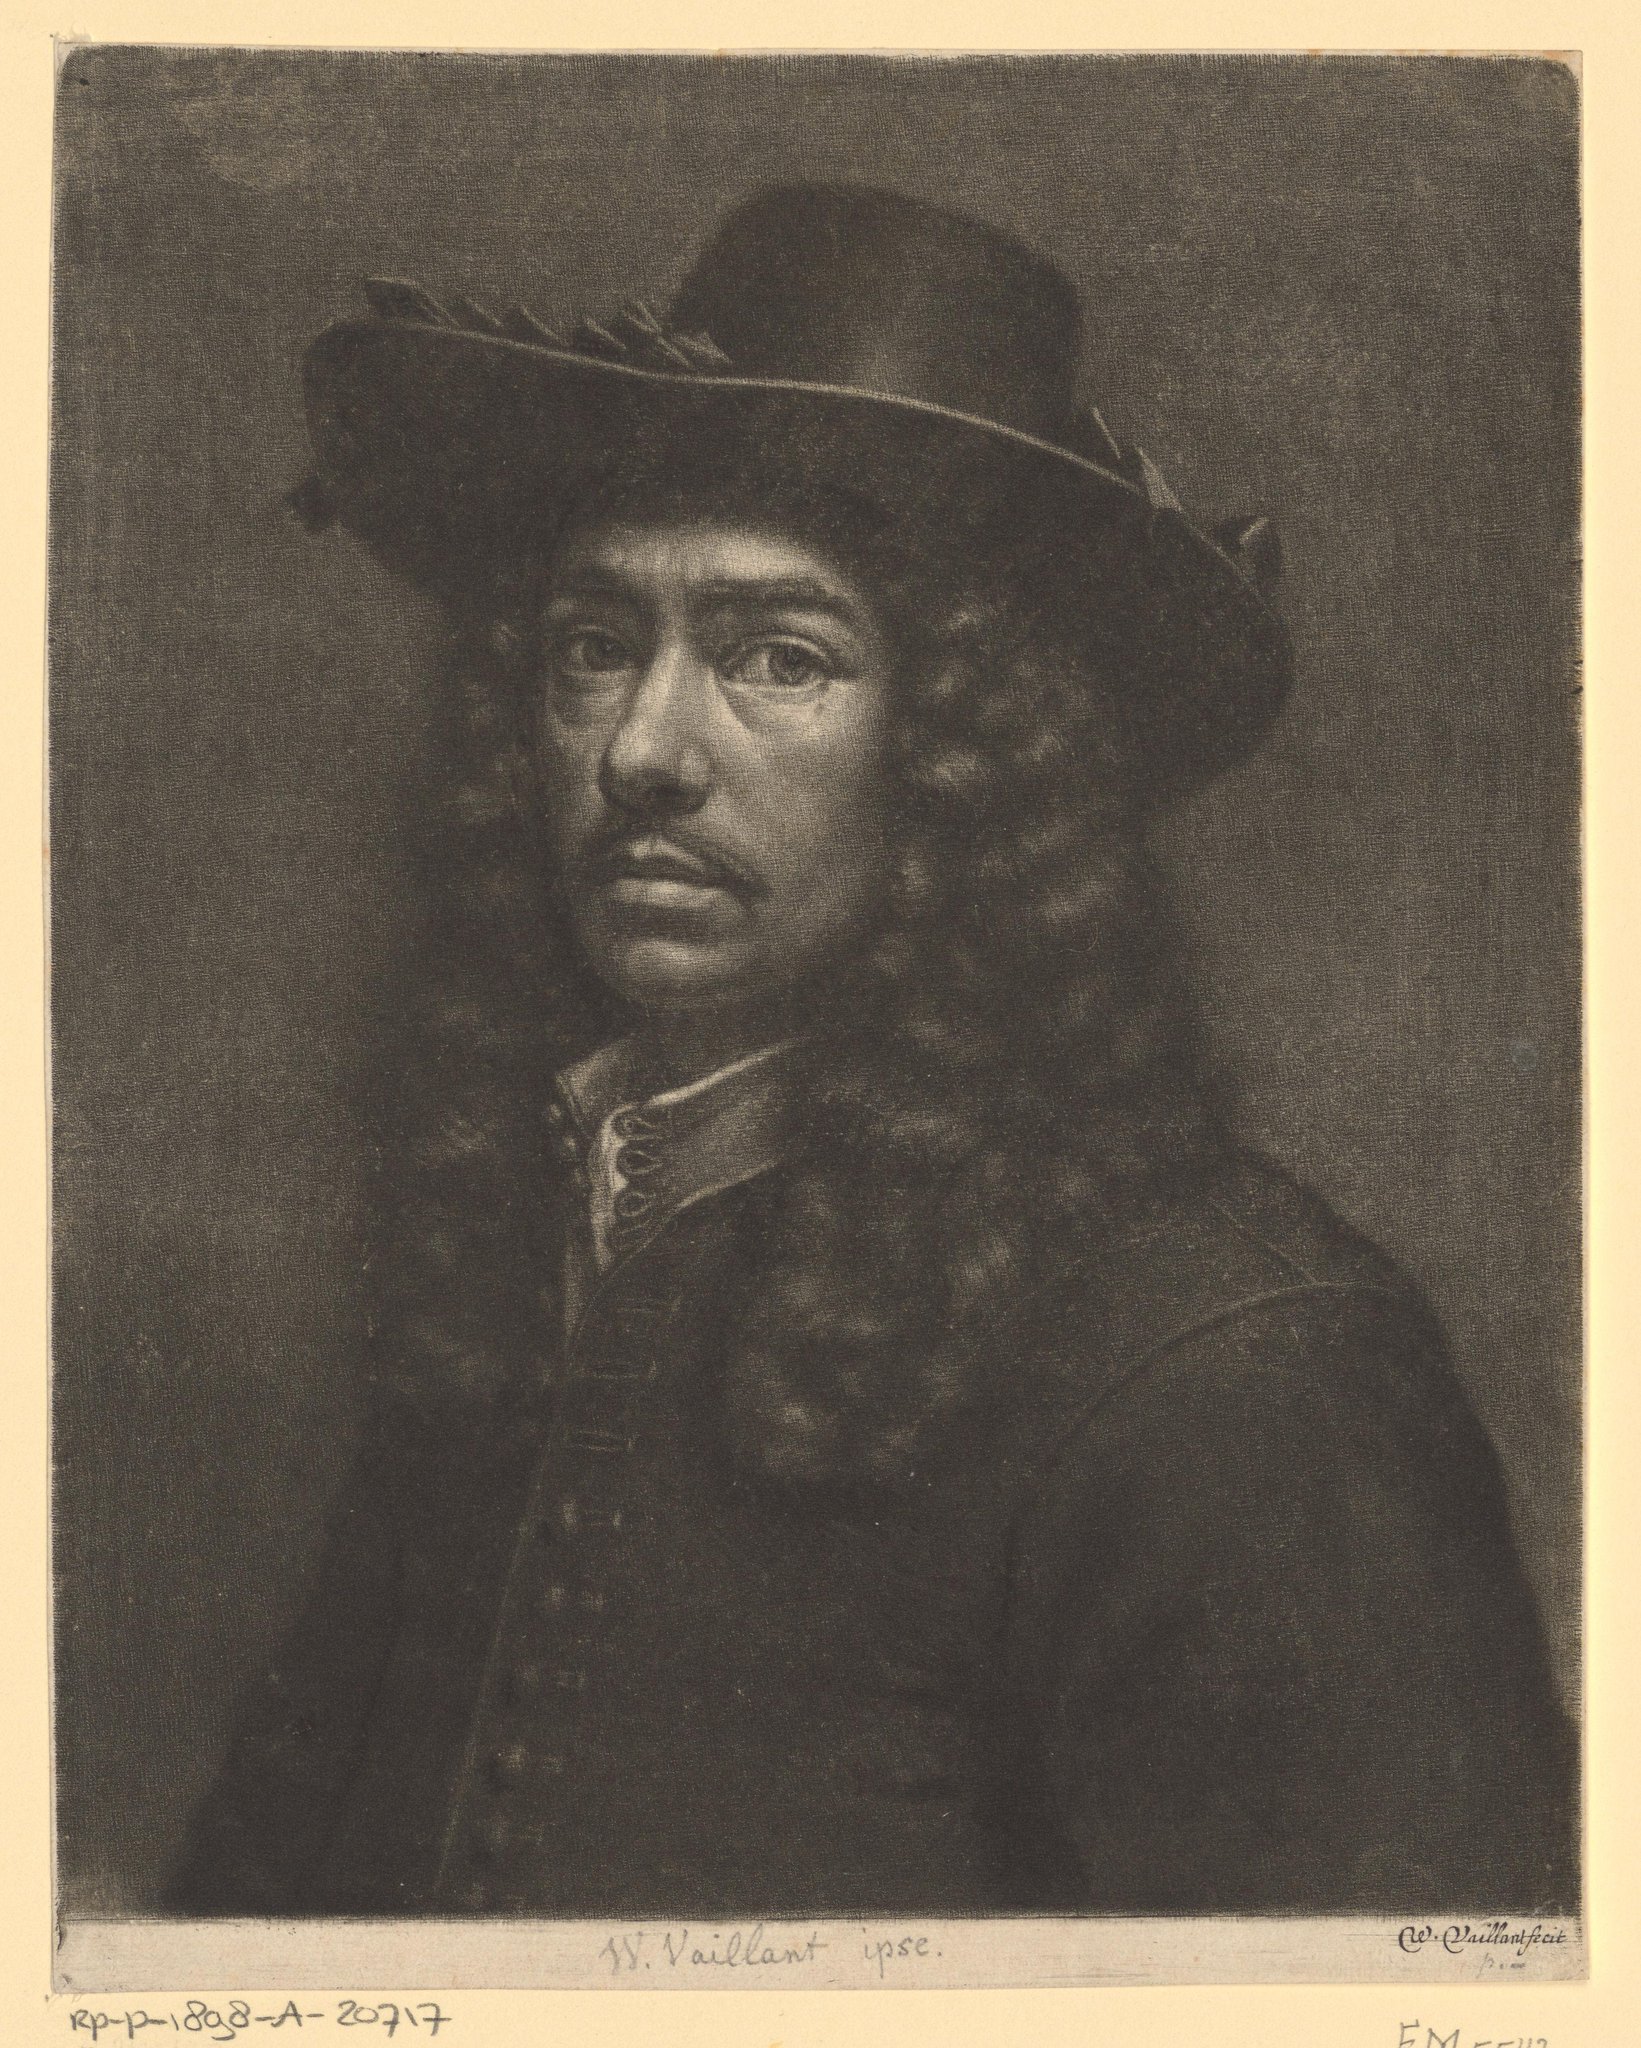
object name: print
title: Zelfportret met hoed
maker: wallerant vaillant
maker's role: draughtsman, painter, print maker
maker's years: 1623-1677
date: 1660-1677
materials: paper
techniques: mezzotint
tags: lille, amsterdam, painter, print maker, draughtsman, wallerant vaillant, historical persons, portrait, self-portrait of graphic artist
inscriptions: collector's mark: Lugt 964